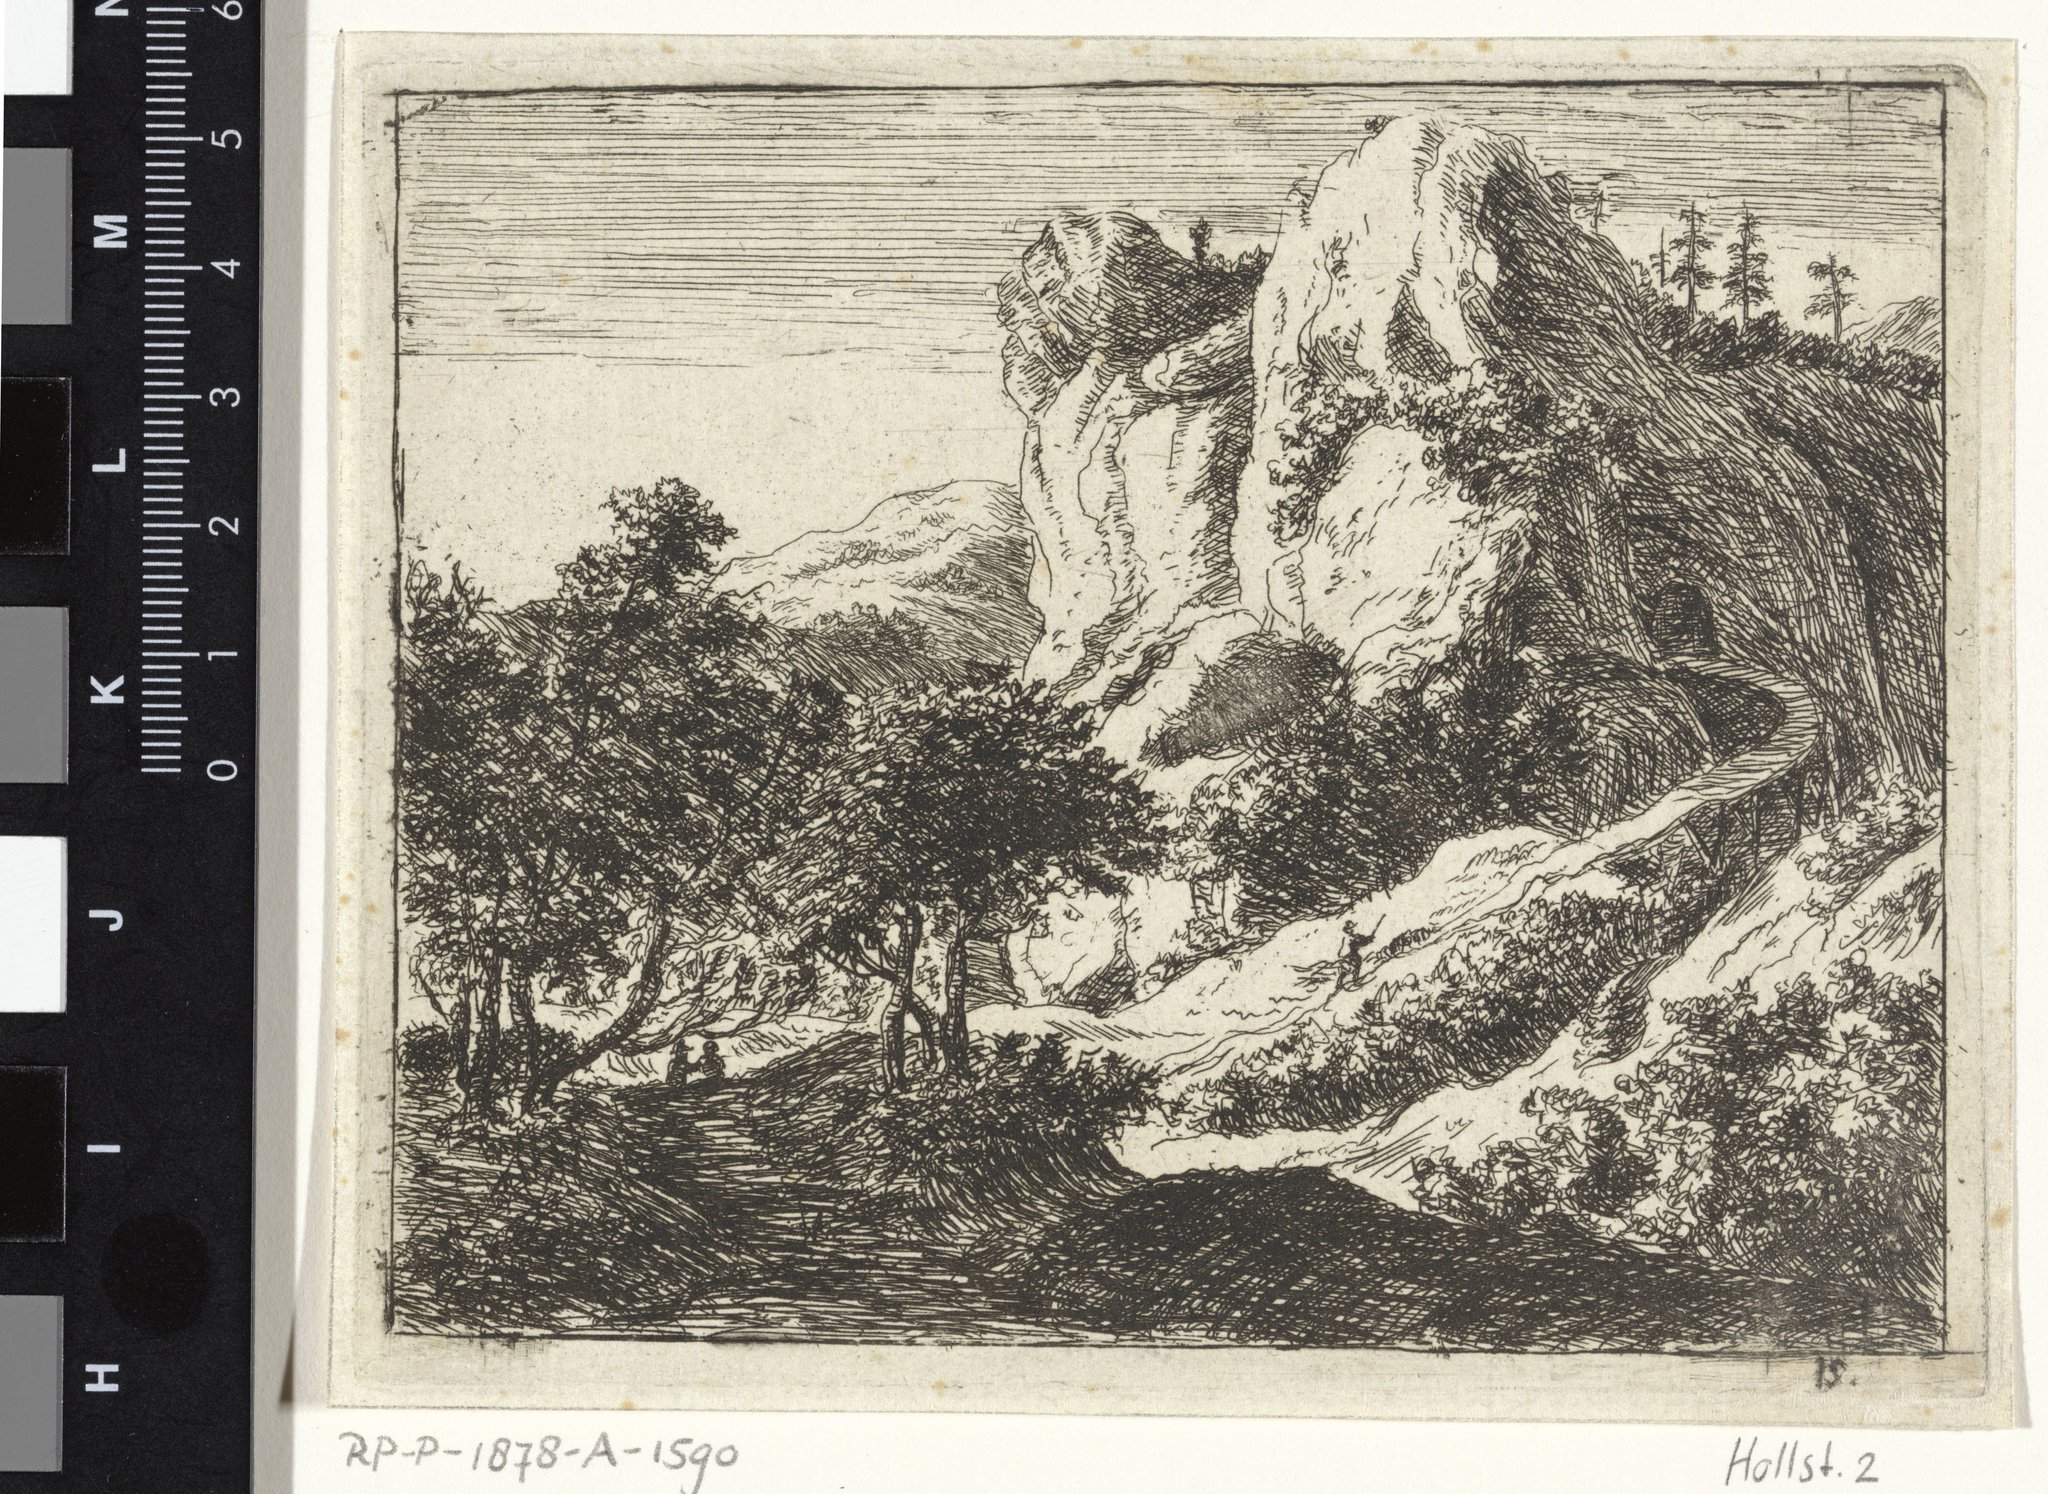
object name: print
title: Berglandschap met wandelaars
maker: jan soukens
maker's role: print maker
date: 1678-1725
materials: paper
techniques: etching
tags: mountains - hh - ideal landscapes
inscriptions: inscription: ‘Jan Soukens’, collector's mark: Lugt 2228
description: Een man beklimt een steile weg, die naar een tunnel door een berg leidt. Op de voorgrond nog twee wandelaars op een door bomen omzoomde weg.